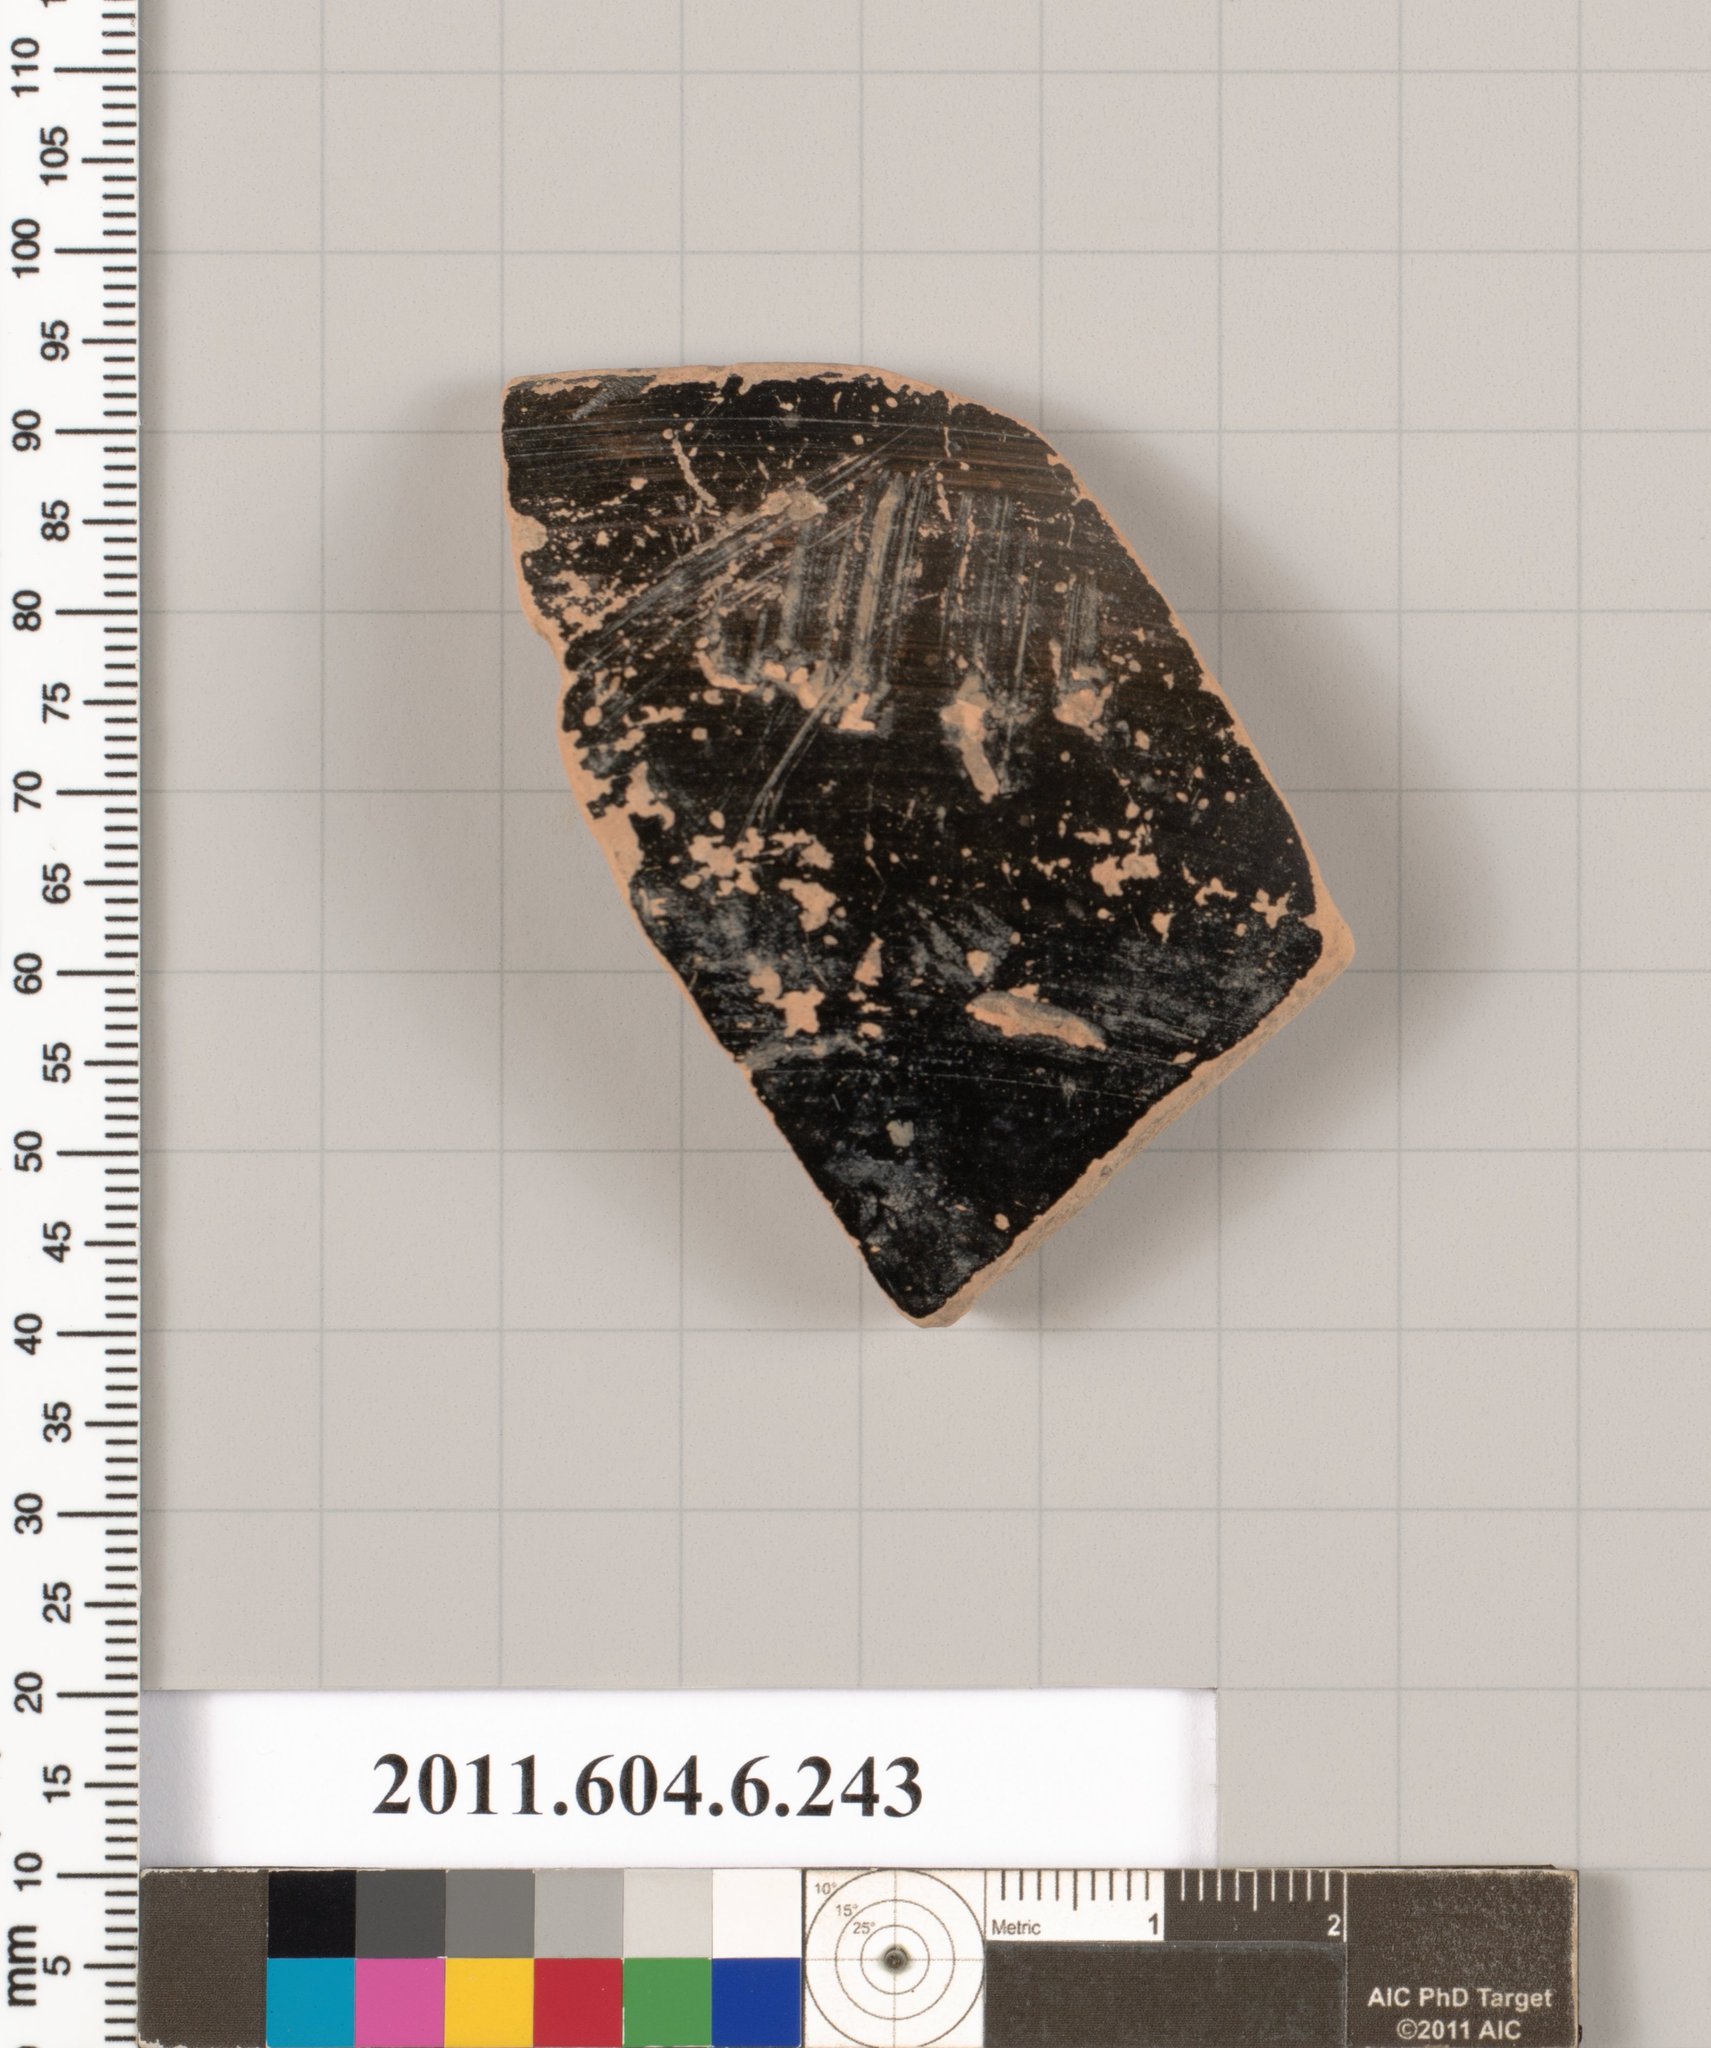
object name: fragment of a bowl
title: Terracotta rim fragment of a bowl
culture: greek, attic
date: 500-301 BCE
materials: terracotta